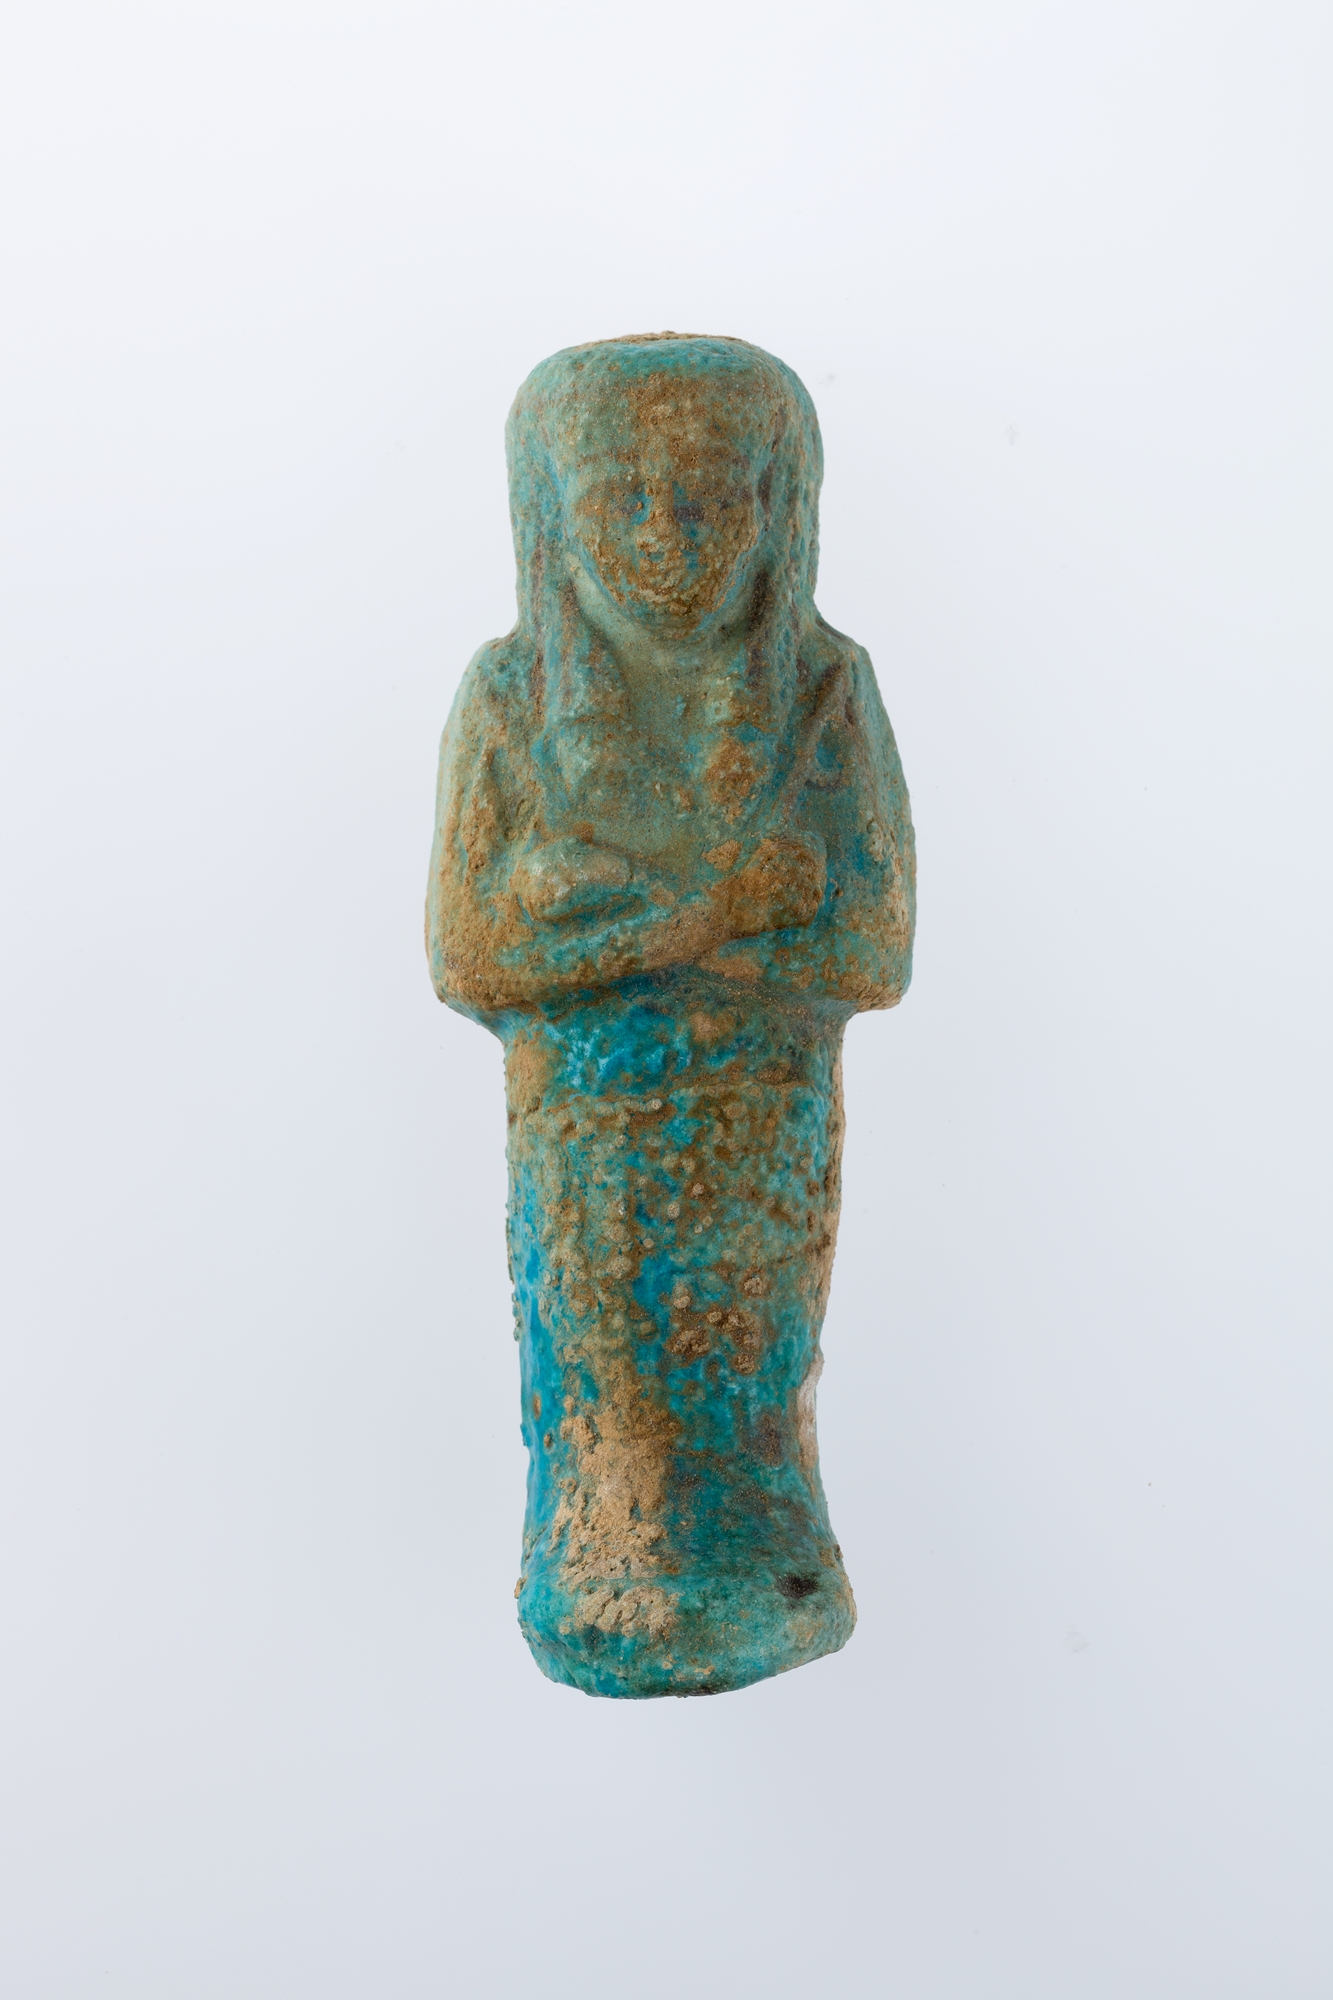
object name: shabti, henettawy c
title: Worker Shabti of Henettawy (C), Daughter of Isetemkheb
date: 990-970 BCE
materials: faience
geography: egypt